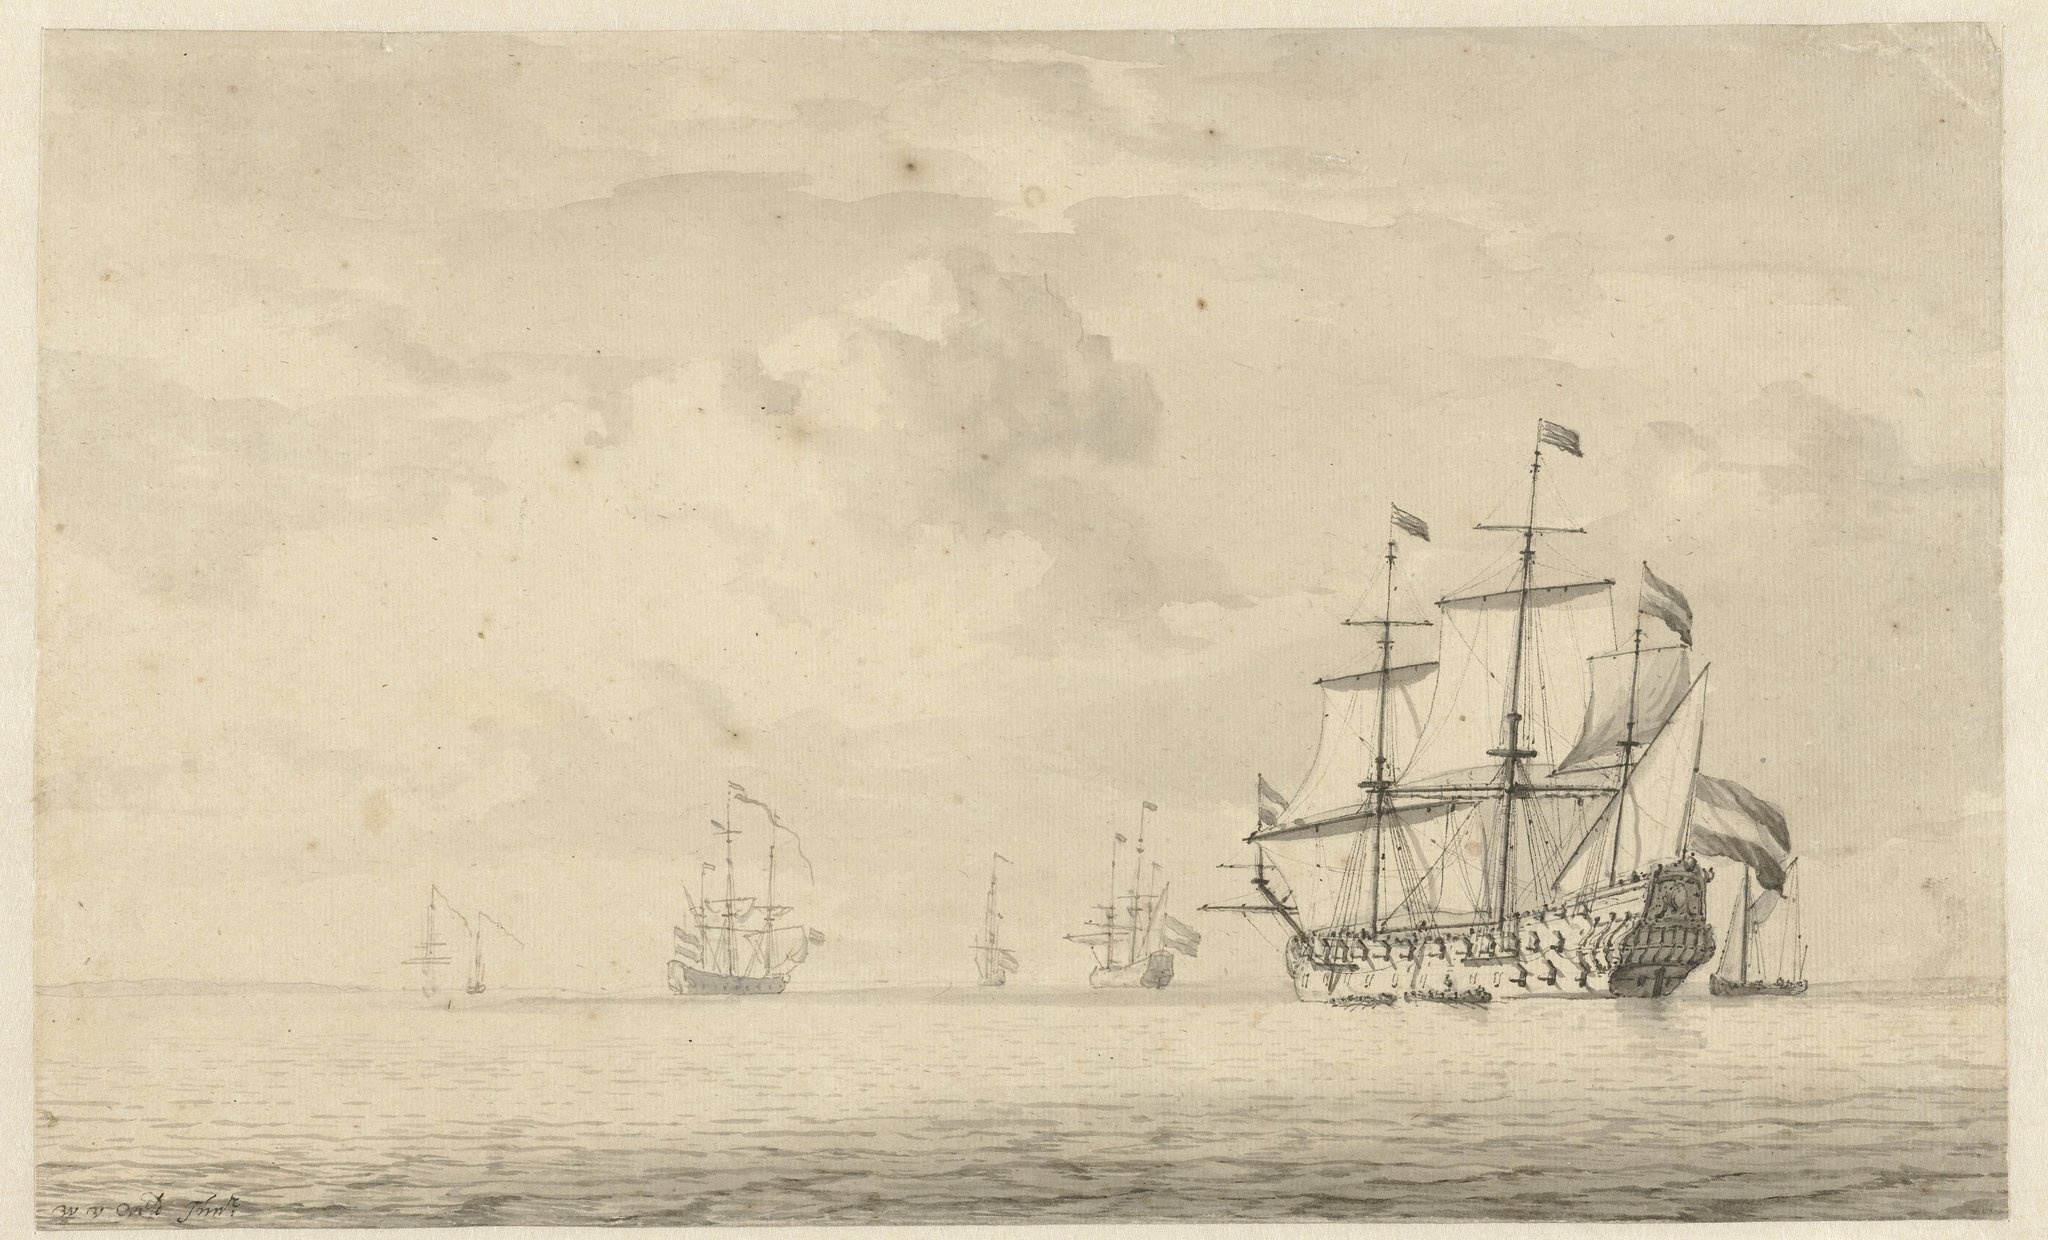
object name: drawing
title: Stille zee met enkele oorlogsschepen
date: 1621-1707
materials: ink, paper, pencil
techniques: brush, pen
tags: sailing-ship, sailing-boat, sea (seascape), navy (+ sailing-ships)